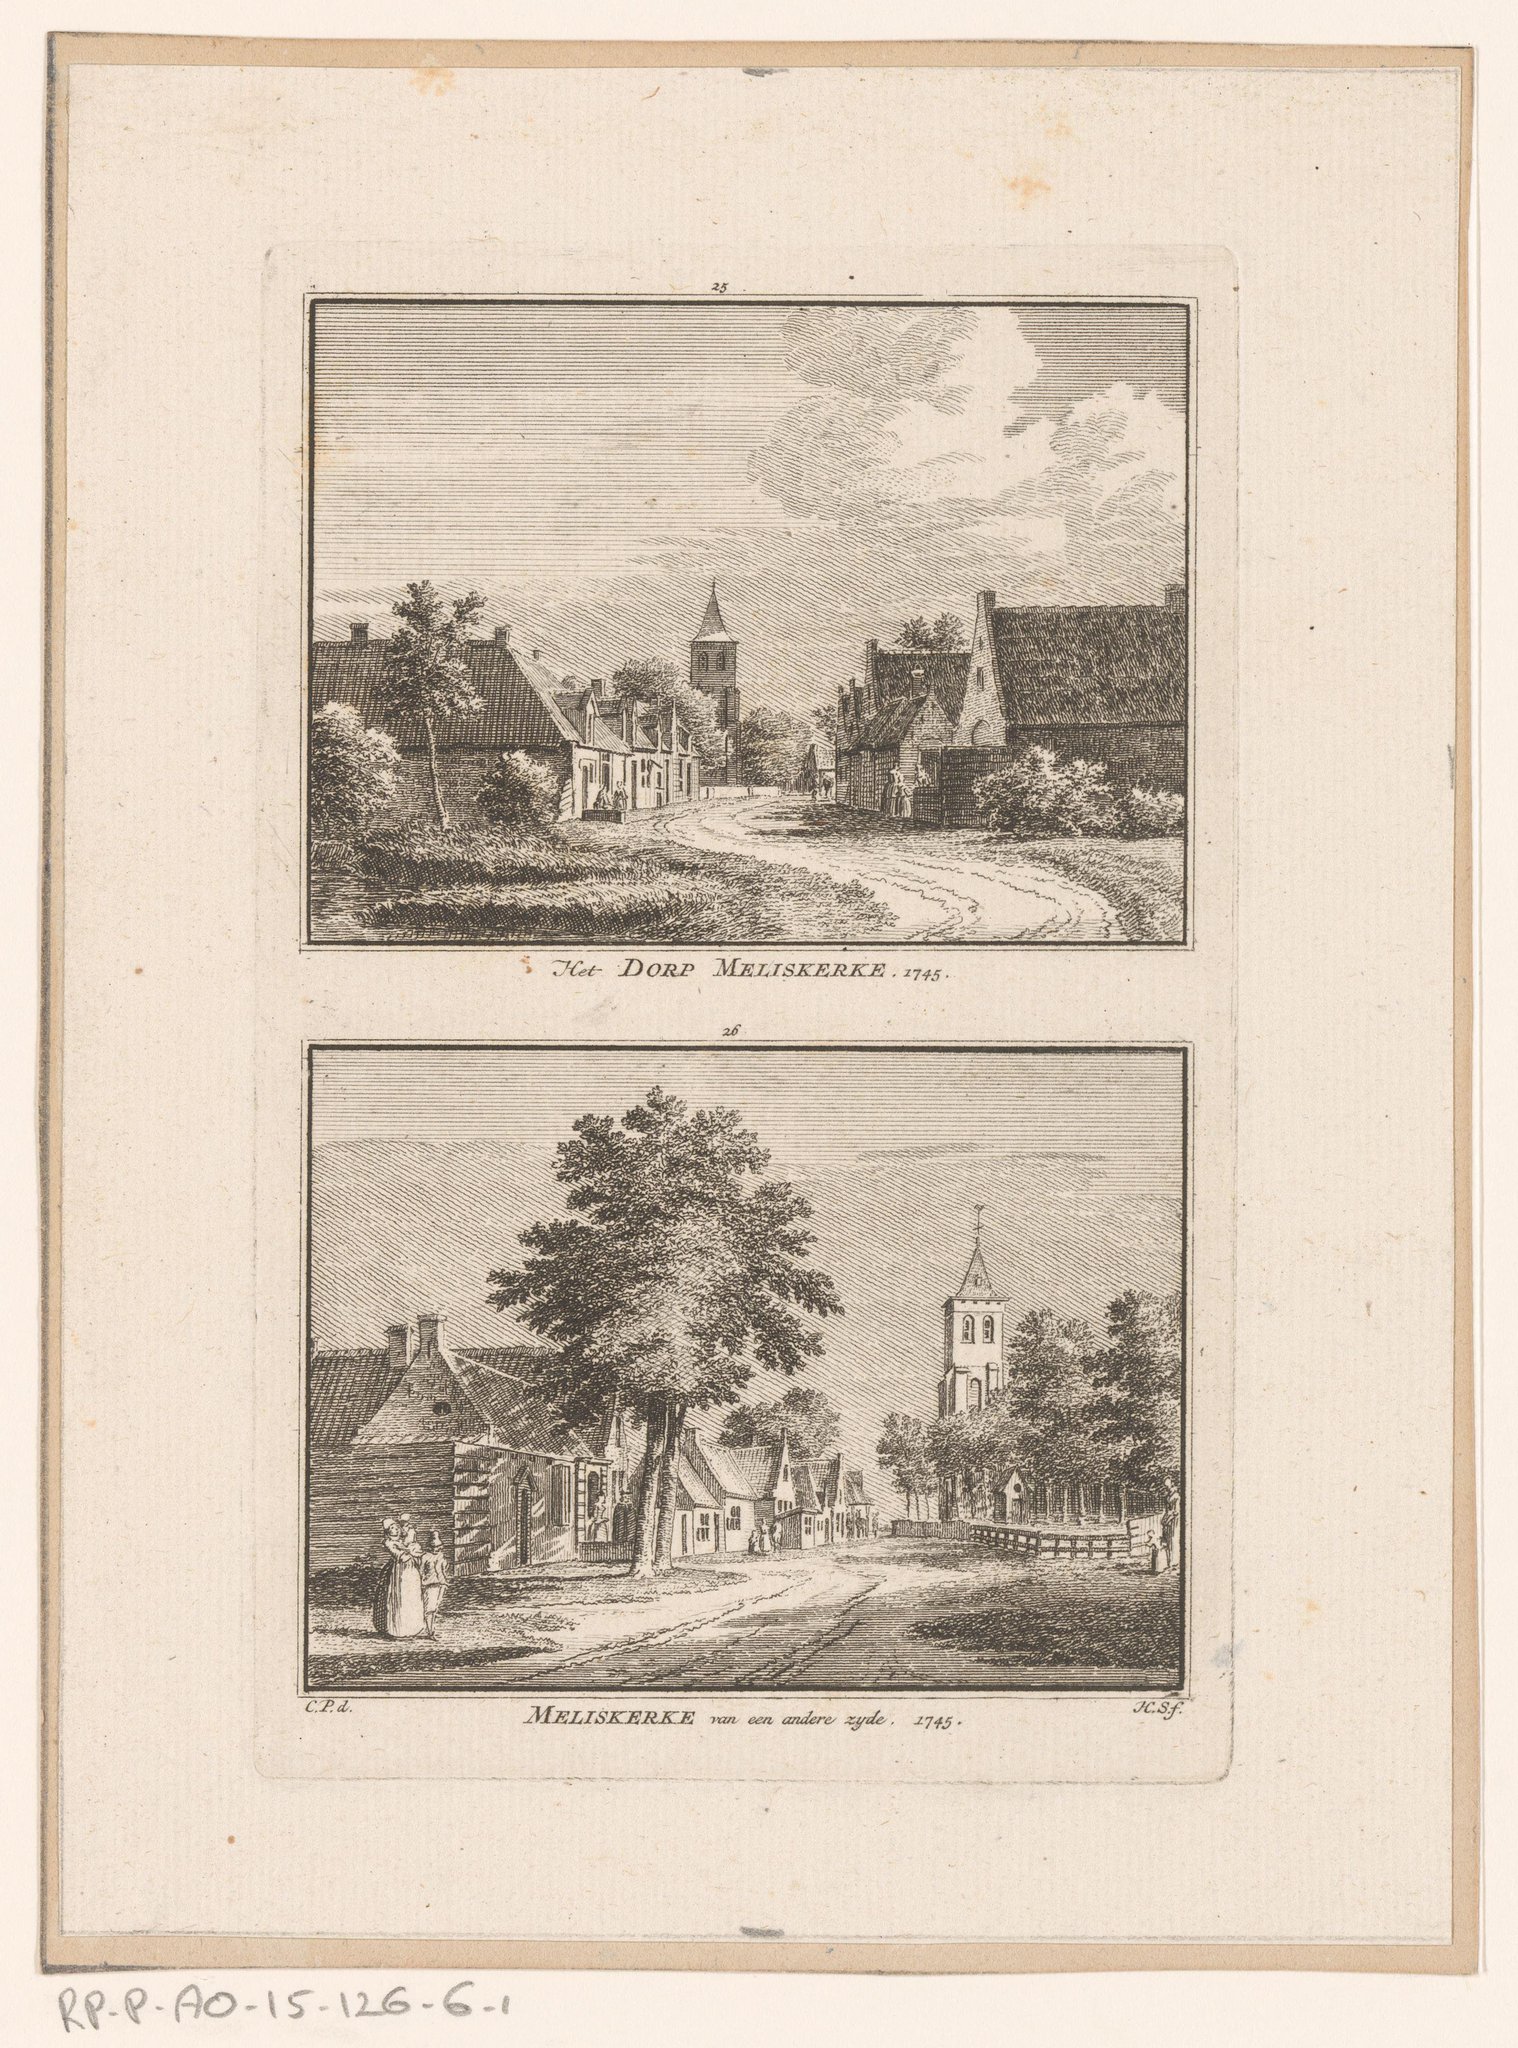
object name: print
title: Het Dorp Meliskerke. 1745 / Meliskerke van een andere zyde. 1745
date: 1754-1792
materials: paper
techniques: etching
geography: haarlem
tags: prospect of village, silhouette of village, church (exterior)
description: Prent ook gebruikt in: Het verheerlykt Nederland of kabinet van hedendaagsche gezigten van steden, dorpen (…). 9 delen. Amsterdam: Isaak Tirion en weduwe Isaak Tirion, 1745-1774, dl. 5 (1754), ill. 25-26. Of in: Nederlandsche tafereelen; of eene keurige verzameling van negen honderd fraaije gezigten van steden, dorpen, sloten, oudheden [….]. 9 delen. Amsterdam: Jan de Groot, 1792, dl. 5, ill. 25-26.